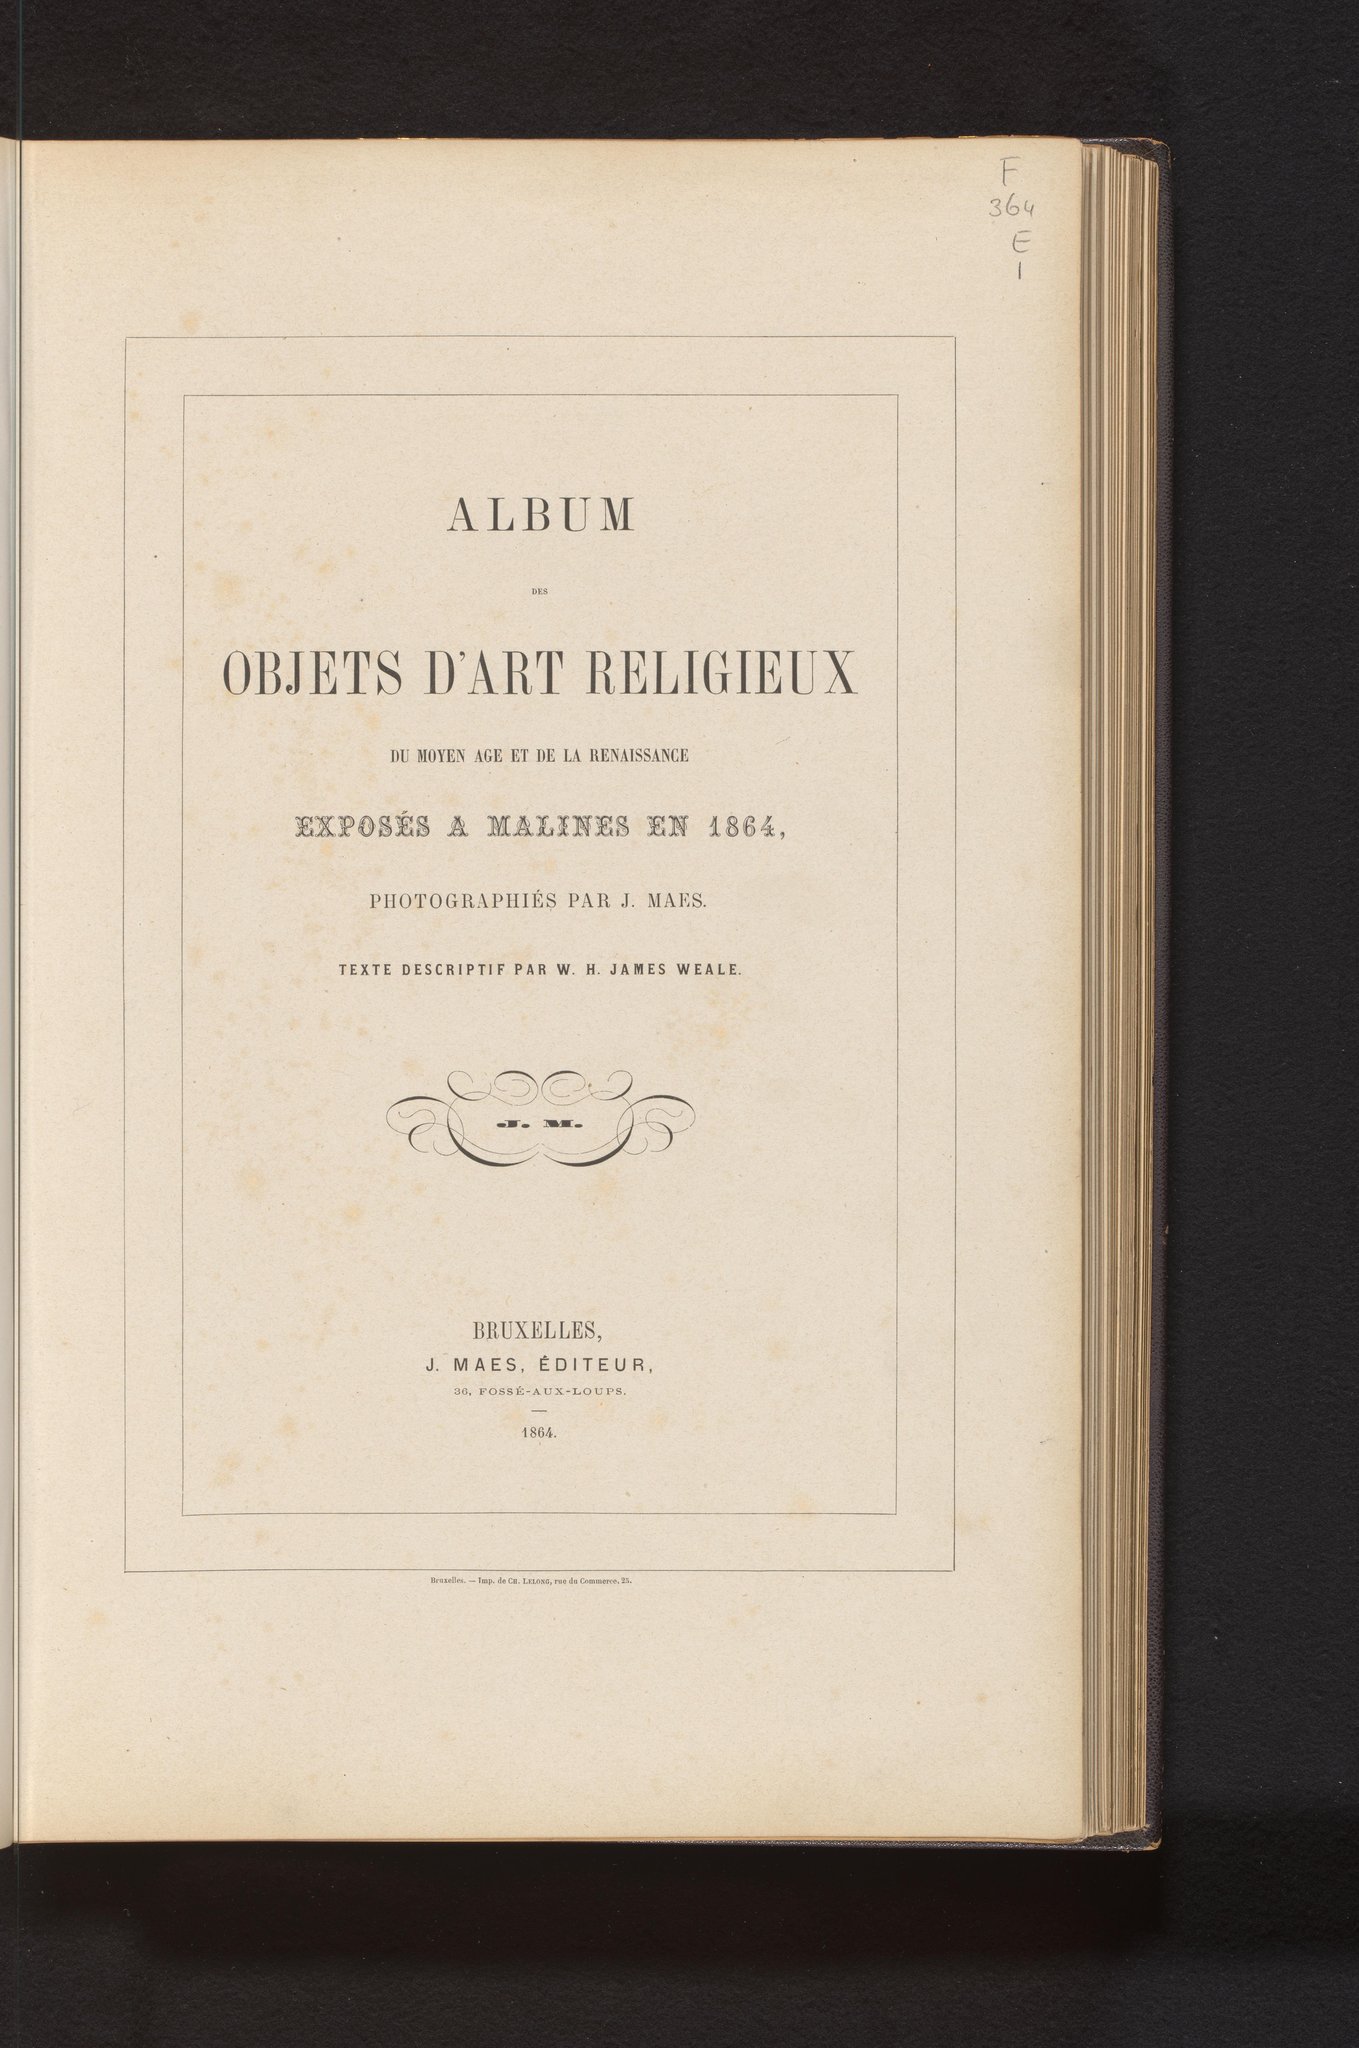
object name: book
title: Album des objects d'art religieux du moyen age et de la renaissance exposés à Malines en 1864 / photogr. par J. Maes; texte desc. par W.H. James Weale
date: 1864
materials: cardboard, leather, linen, paper, photographic support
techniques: albumen print, printing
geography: brussels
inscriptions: annotation: ‘Important par [...], bronzes/ et orfevrerie anciens -/ Plusieurs des pieces reproduites/ sont aujourd'hui perdues’